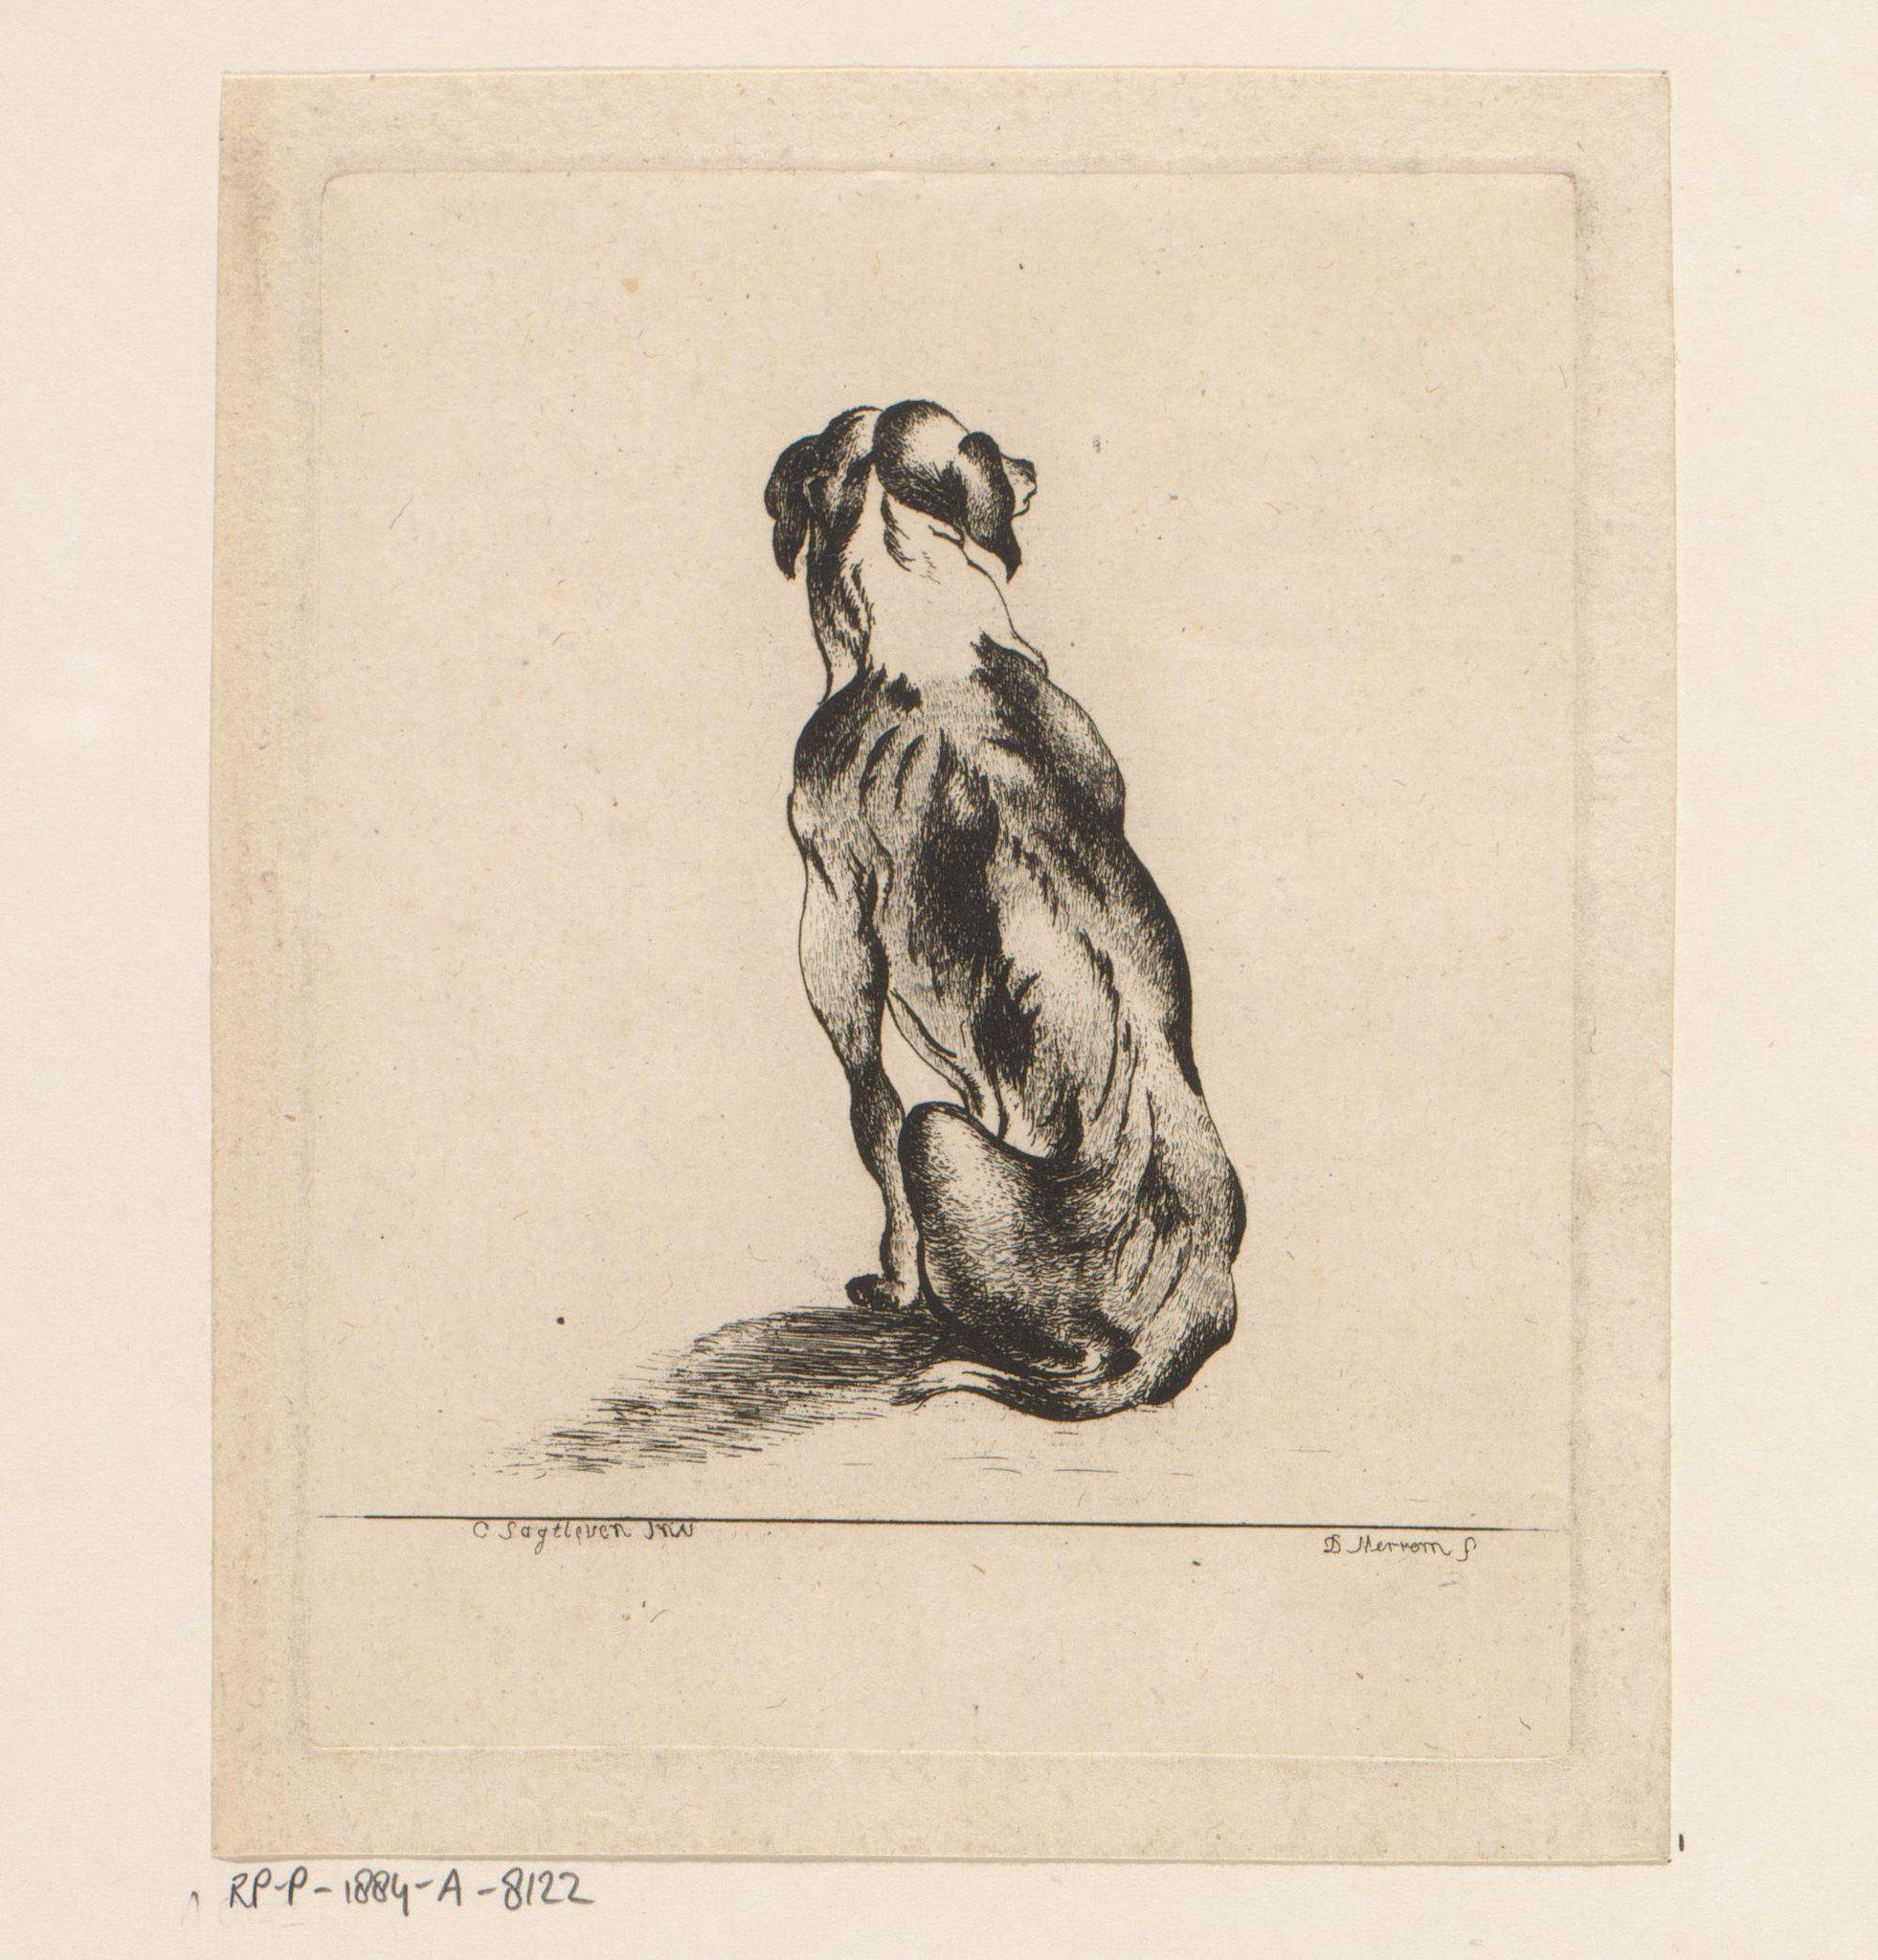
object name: print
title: Zittende hond op de rug gezien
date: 1700-1800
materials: paper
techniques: etching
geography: netherlands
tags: dog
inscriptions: collector's mark: Lugt 2228